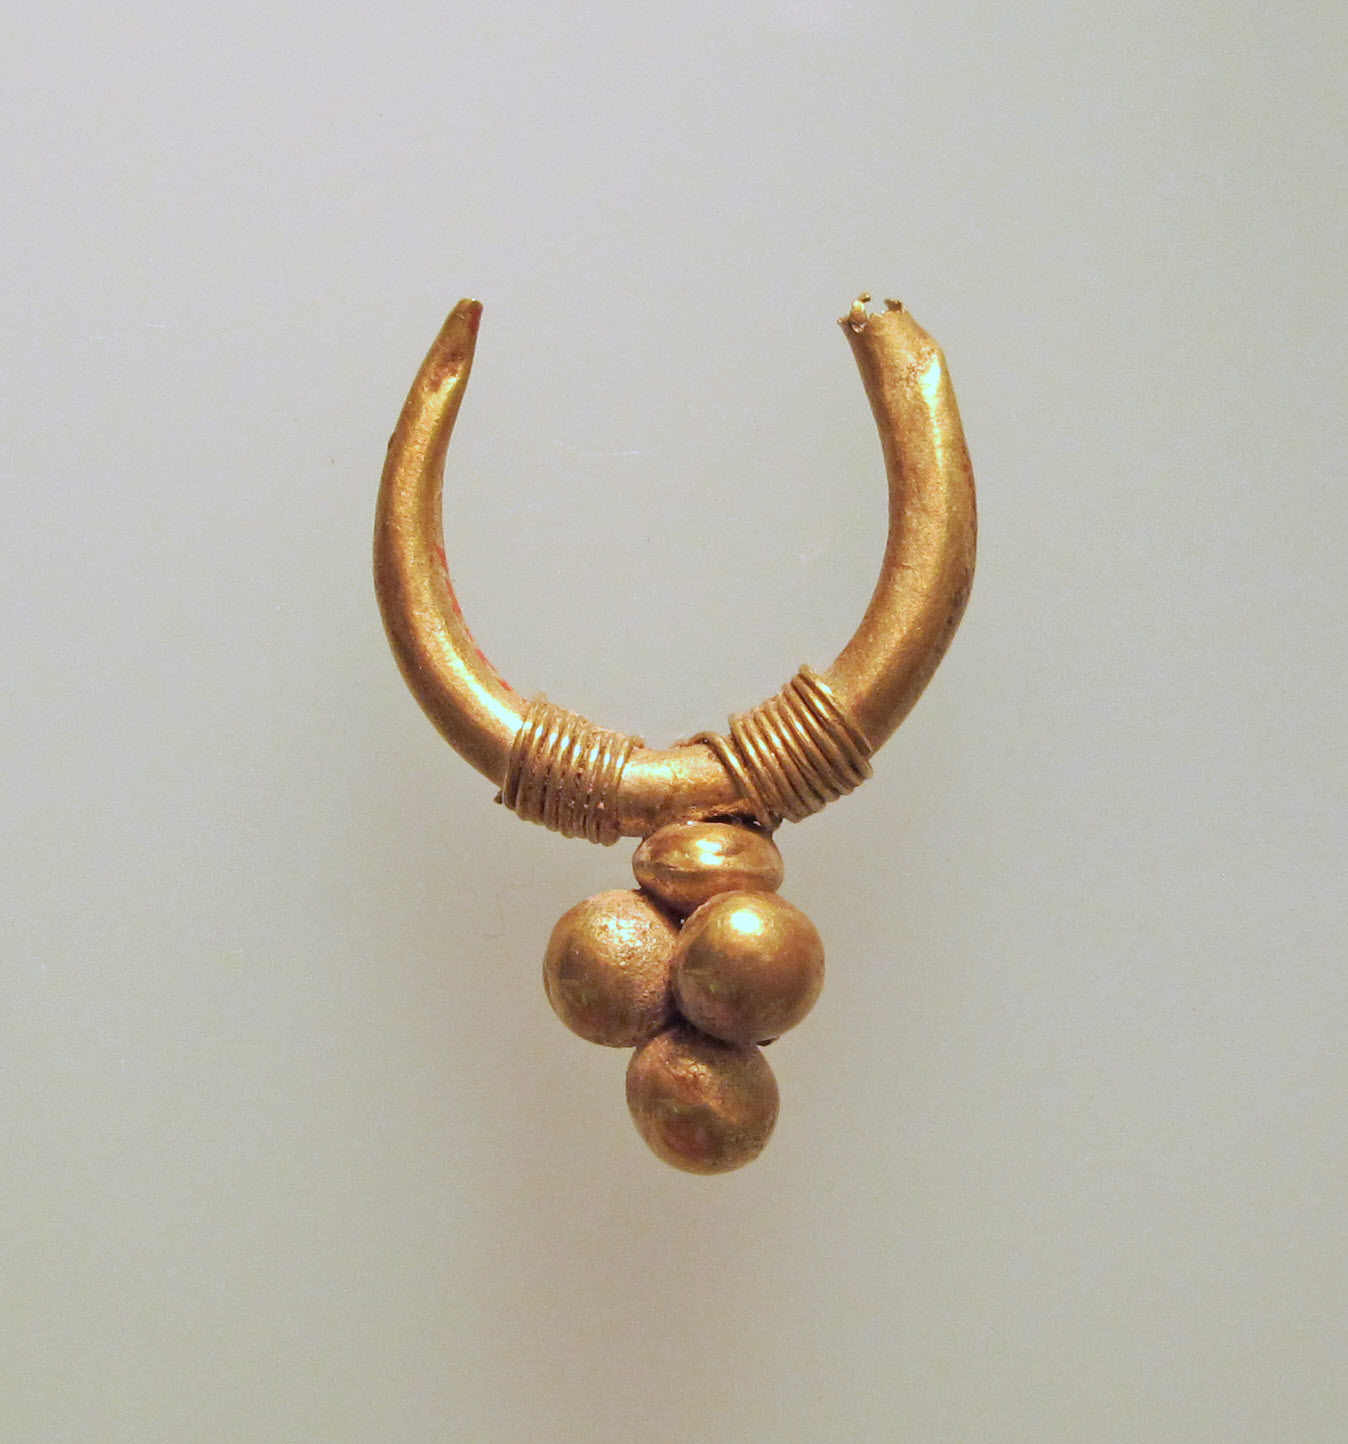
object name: earring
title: Earrings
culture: cypriot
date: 3900 BCE-100 CE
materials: gold